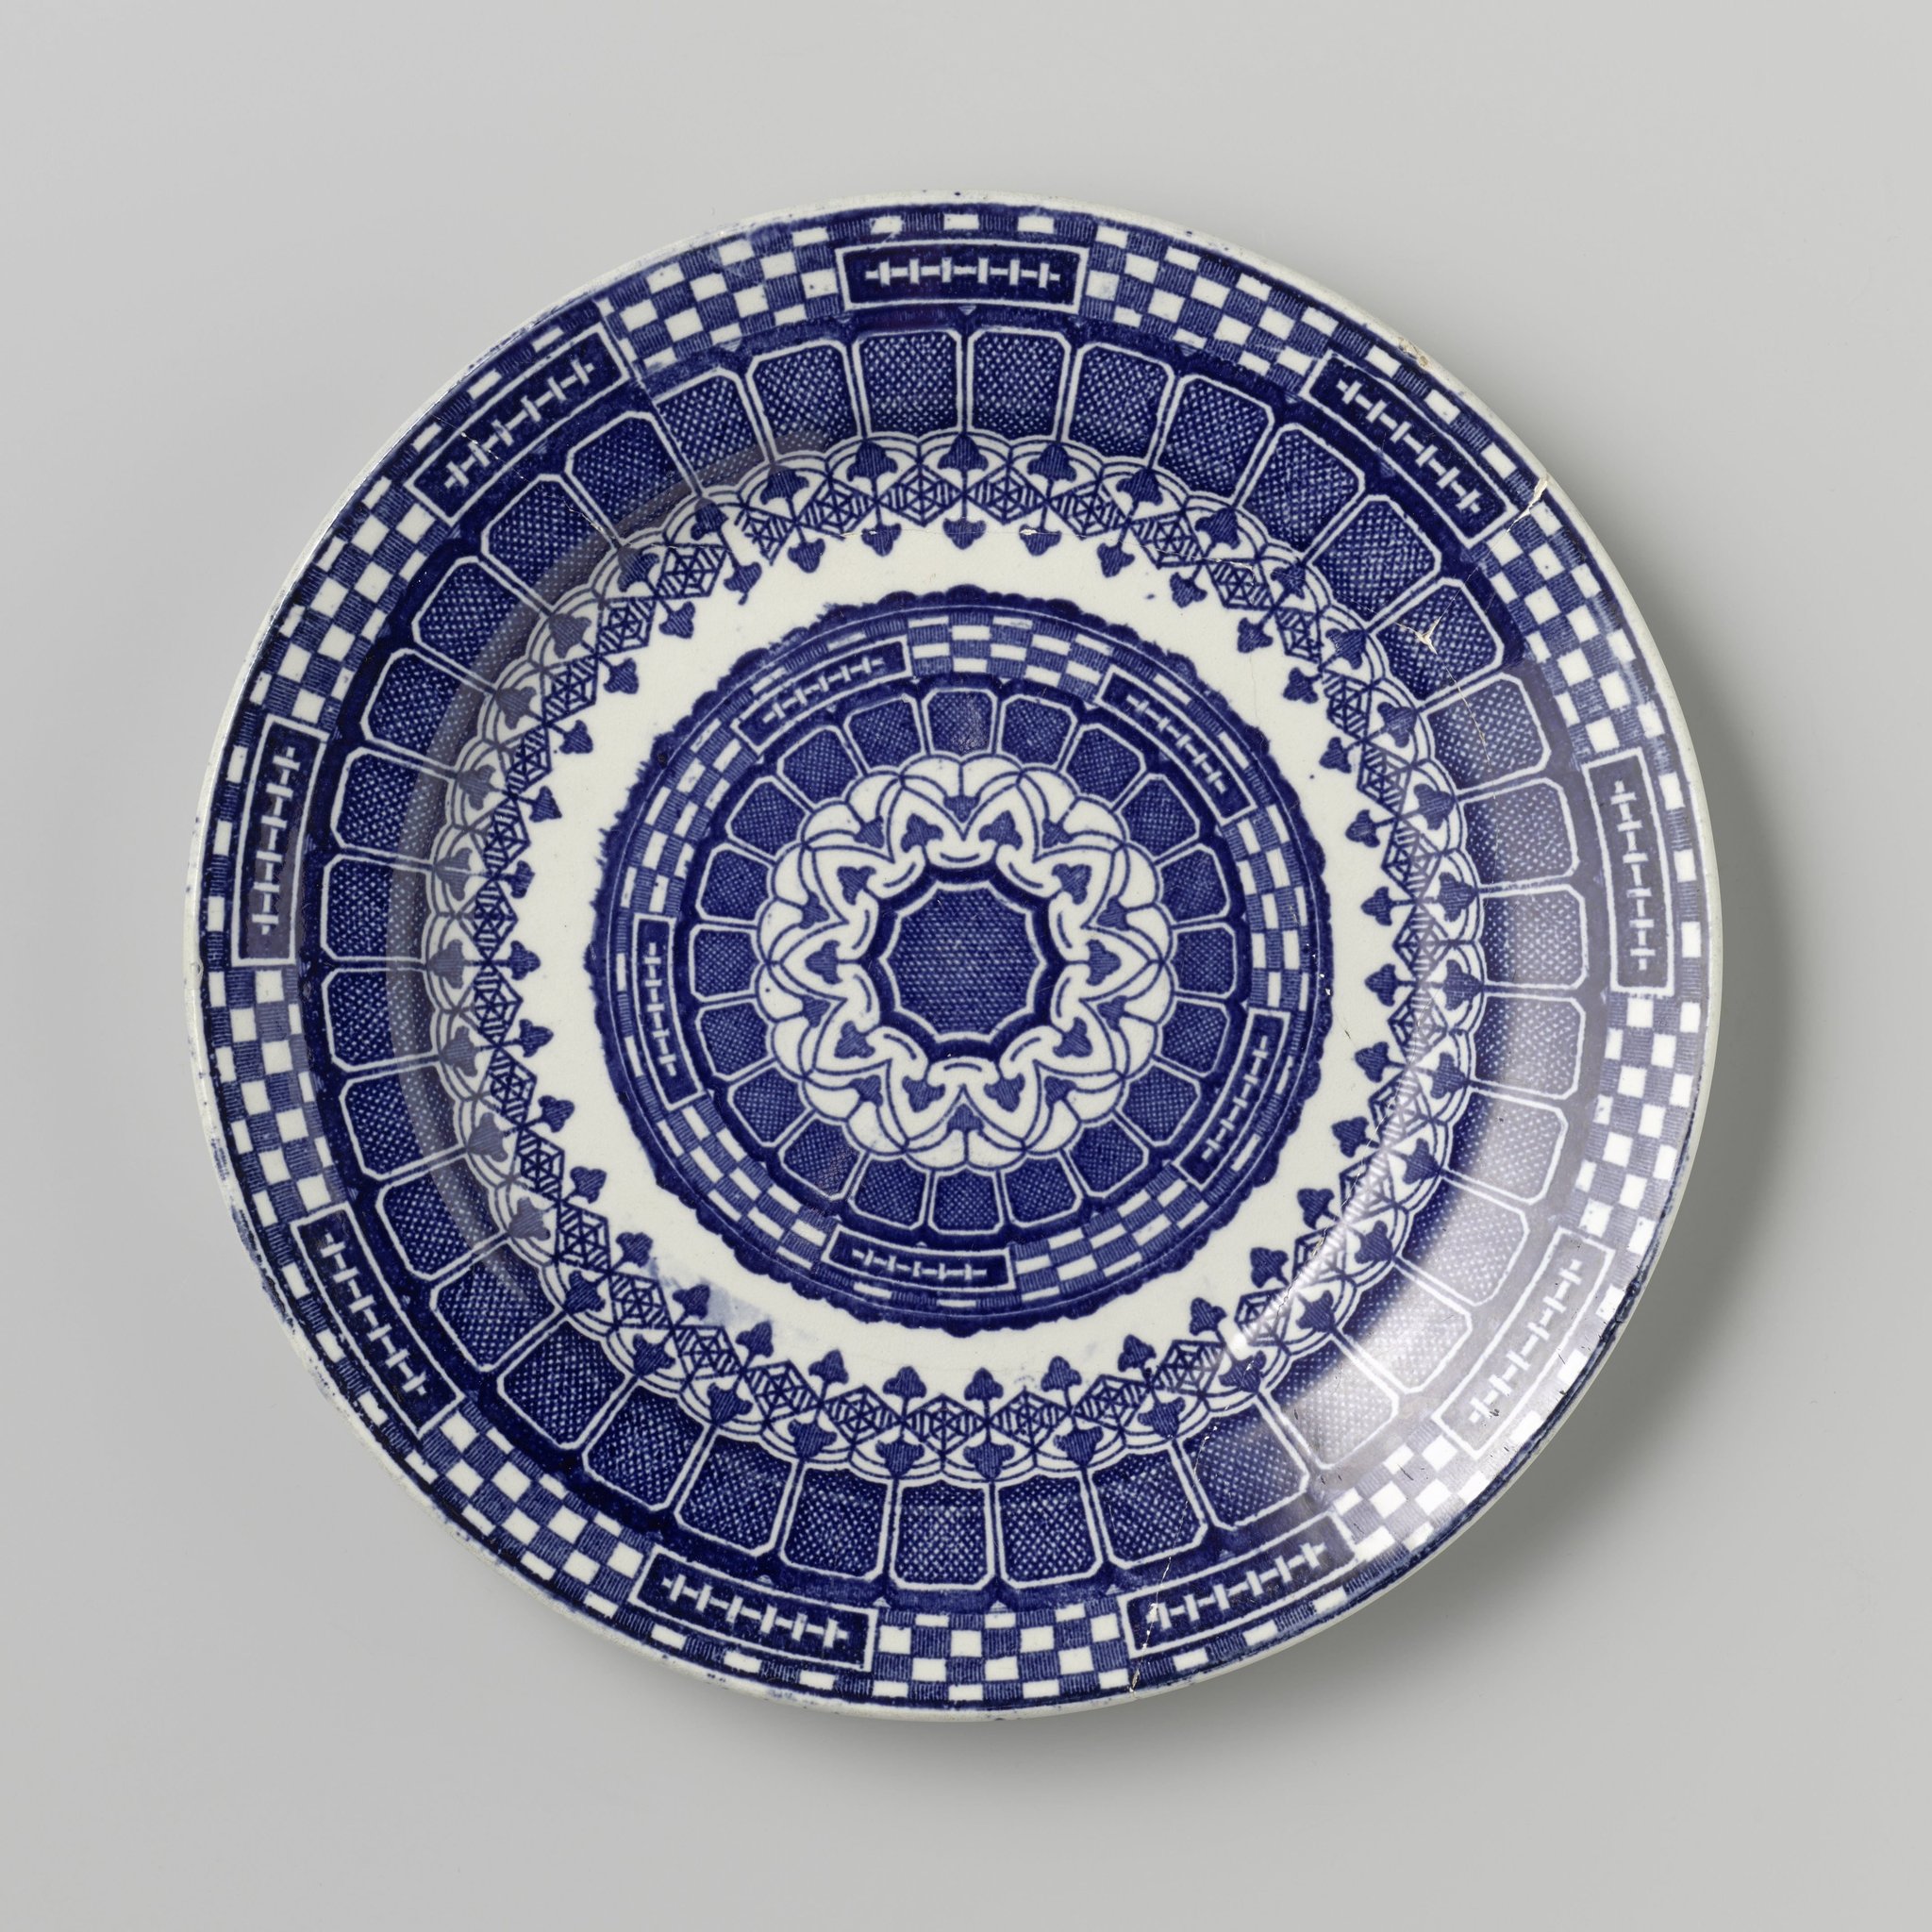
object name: plate dish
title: Bord met op het plat een gestileerde bloem omgeven door een band met blauwe en witte vlakken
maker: Anonymous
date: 1400-1950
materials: earthenware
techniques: transfer decoration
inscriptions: mark: ‘ALPINE’, check stamp: ‘8 en ... (?)’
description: Bord van aardewerk met vloeiblauw transferdecor. Het plat met een soort van gestileerde bloem omgeven door een band met vakken en blauwe en witte blokken. De rand van het bord met vakken en blauwe en witte blokken.